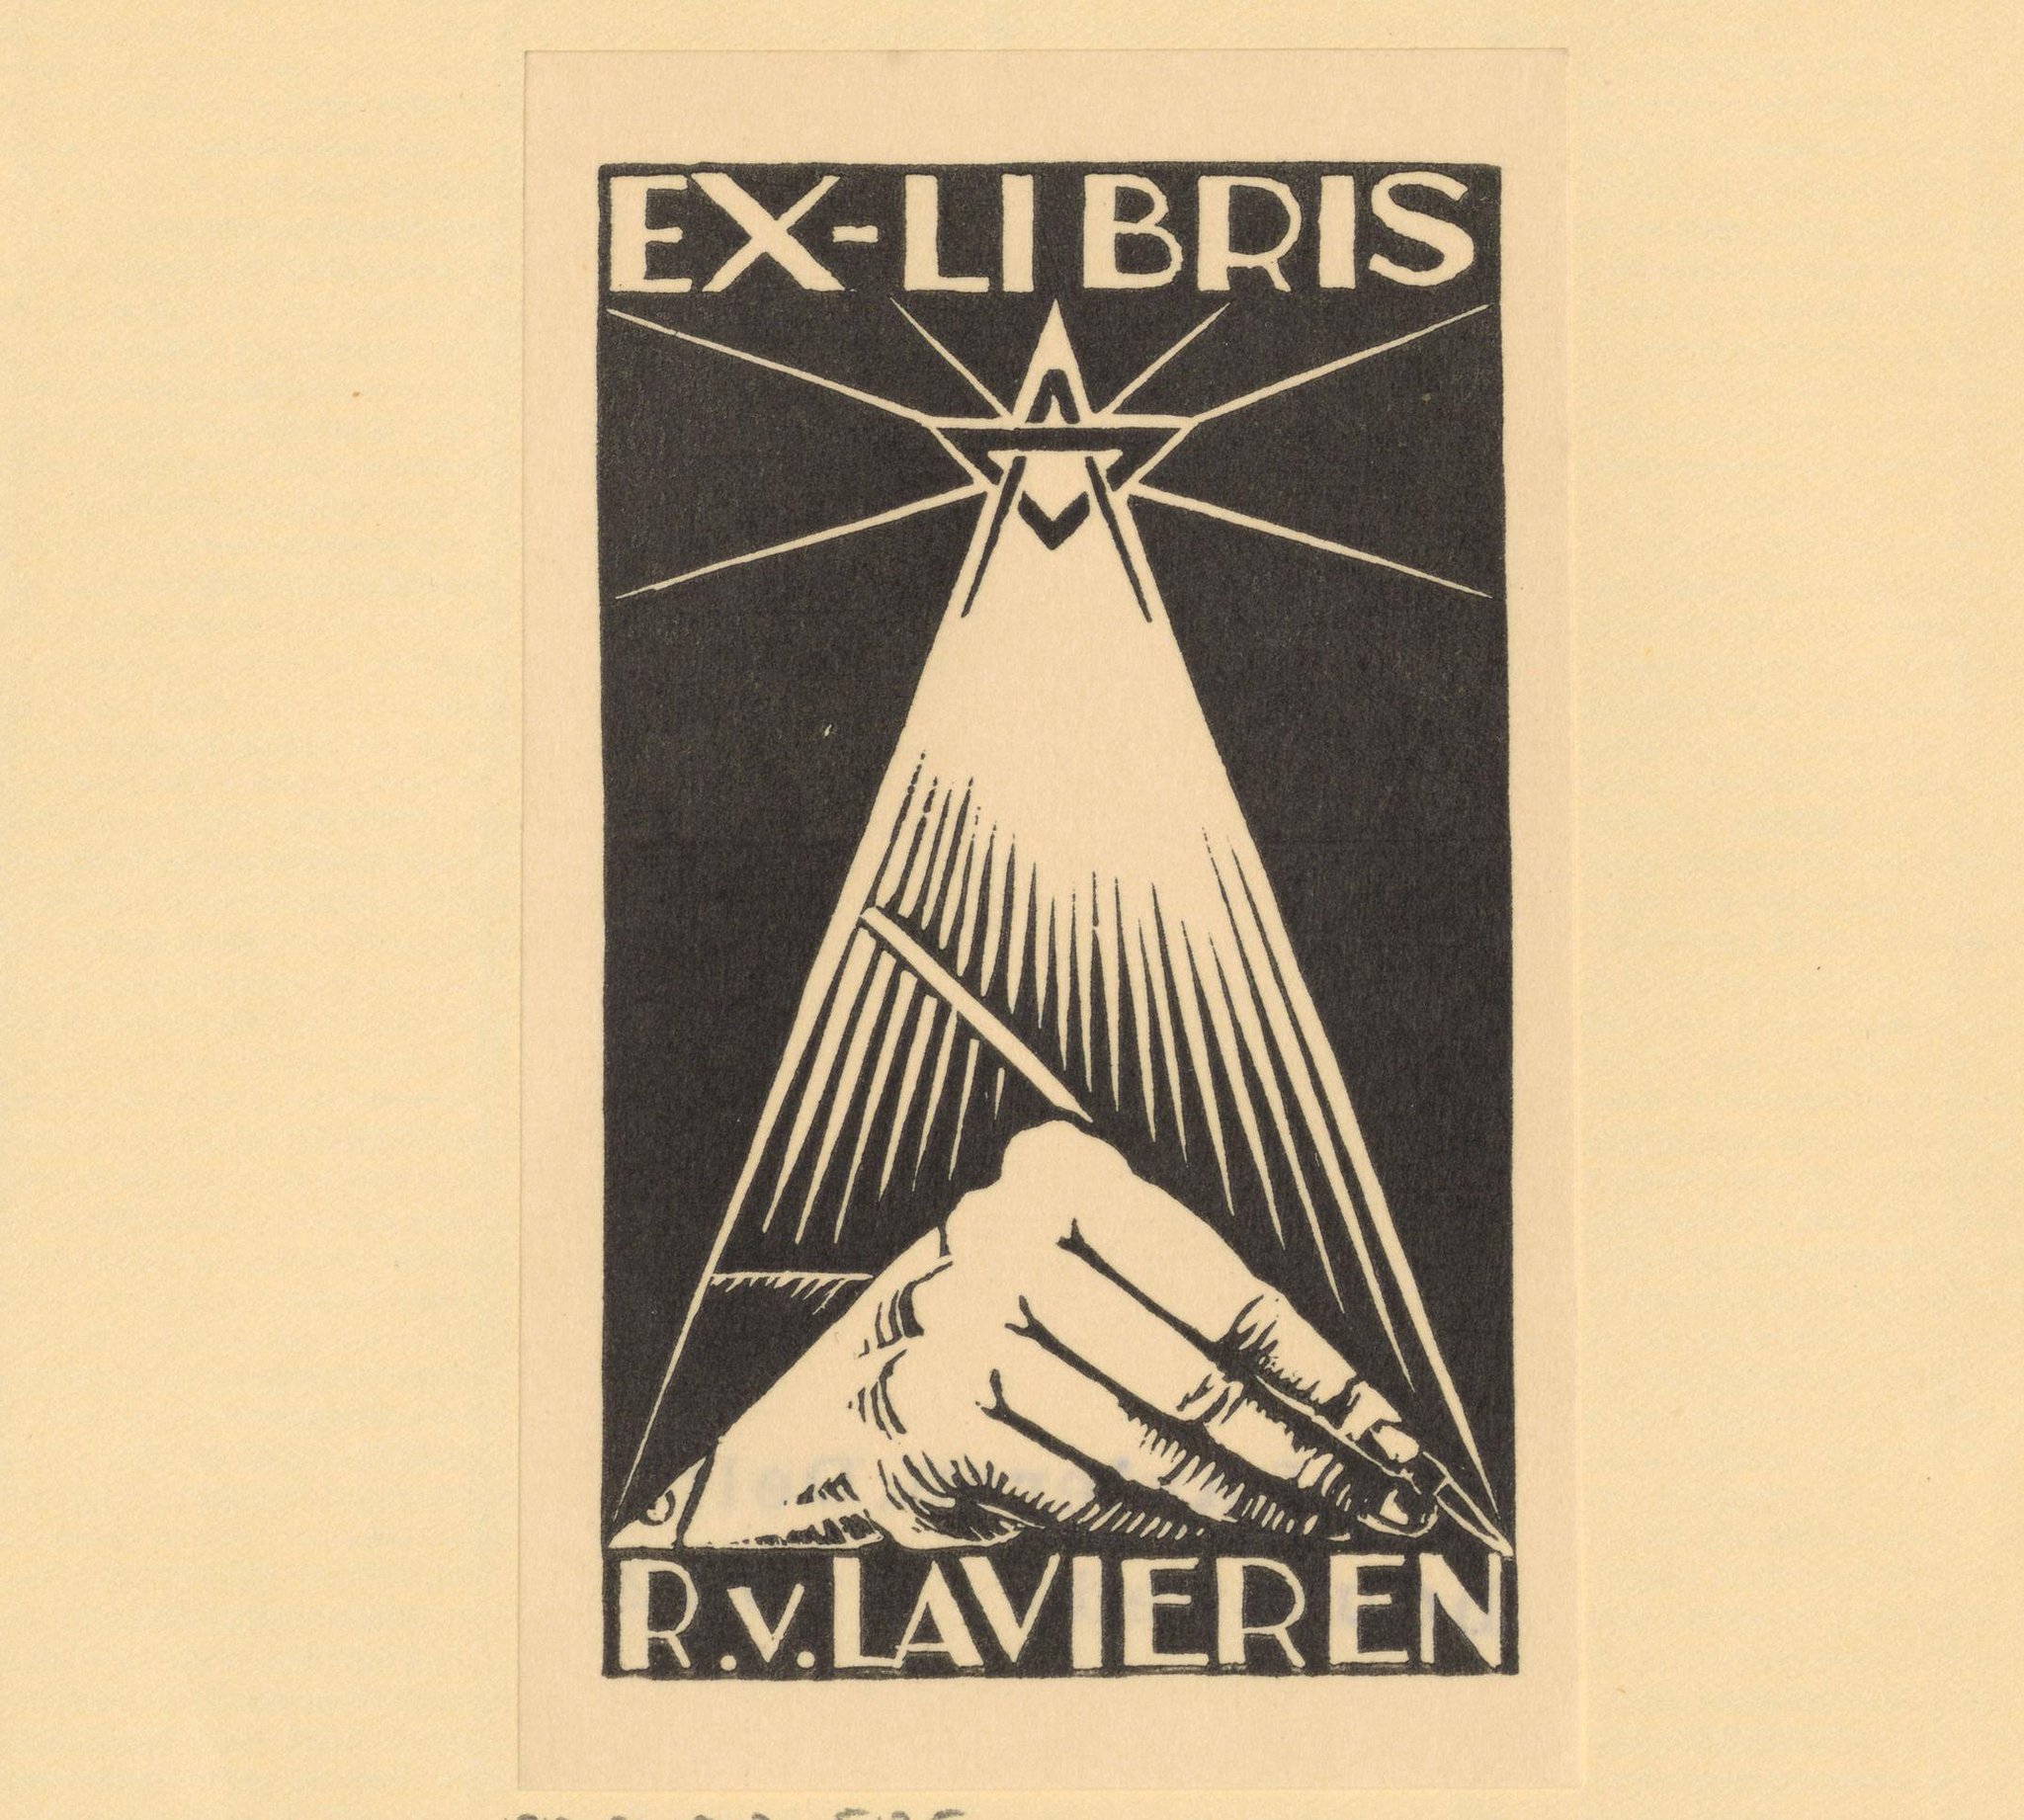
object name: bookplate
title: Ex libris van R. van Lavieren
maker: rijk van lavieren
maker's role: print maker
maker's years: 1889-1952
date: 1932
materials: paper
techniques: woodcut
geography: delft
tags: delft, print maker, rijk van lavieren, hand, stars, painting (including book-illumination, miniature-painting), tools, implements of architect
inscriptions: workshop stamp: ‘R.v.Lavieren, Delft / houtsnede 1932’